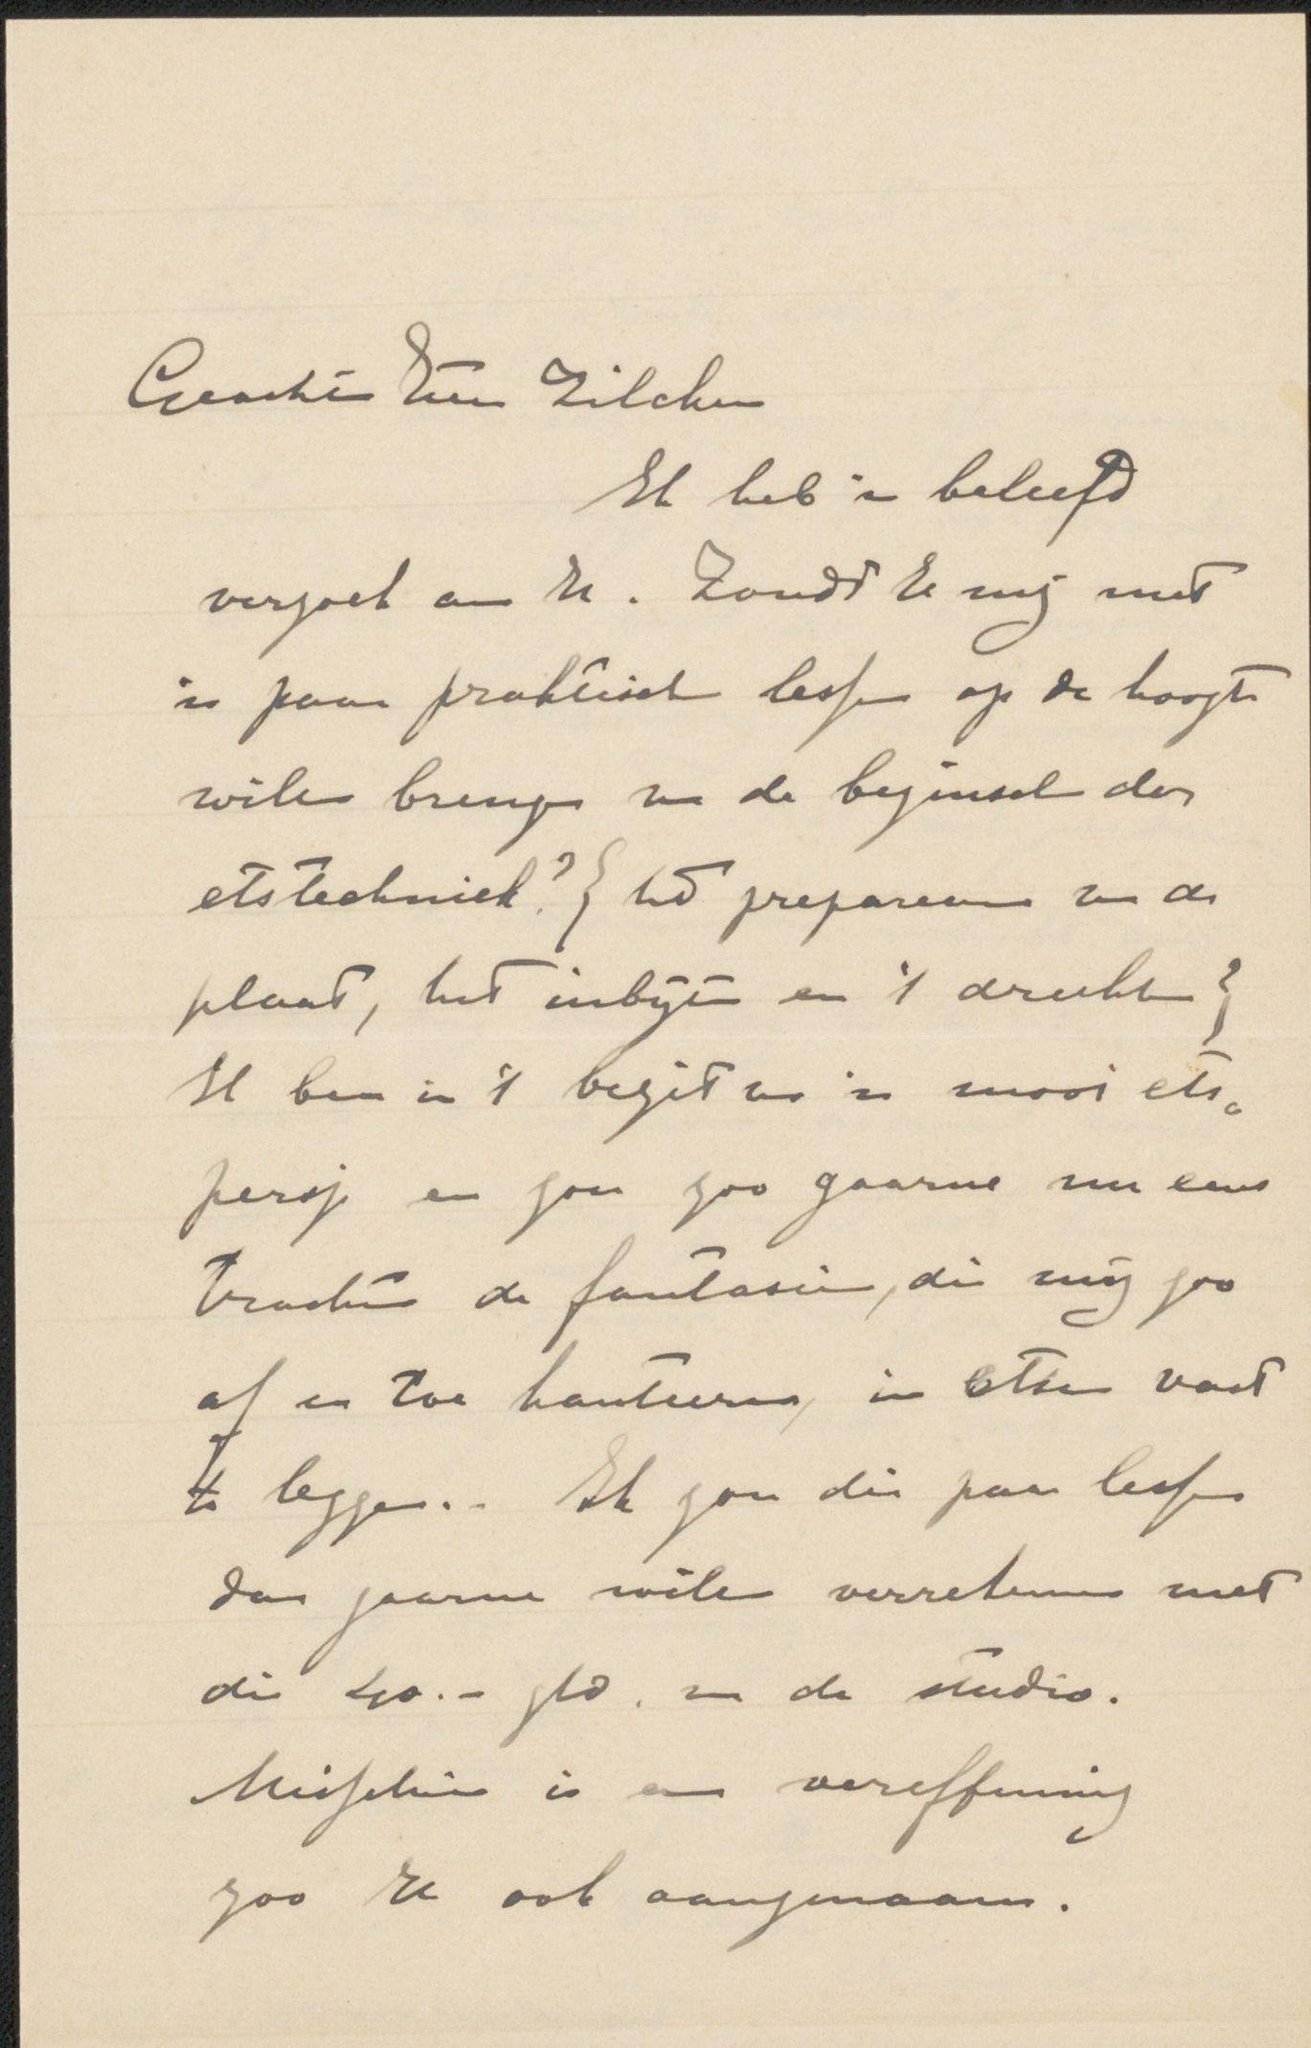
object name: letter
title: Brief aan Philip Zilcken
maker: willem jan gerrit van meurs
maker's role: artist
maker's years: 1872-1956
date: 1909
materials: ink, paper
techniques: pen, writing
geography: haarlem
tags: the hague, painter, draughtsman, philip zilcken, the graphic arts, money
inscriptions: collector's mark: ‘RPK’